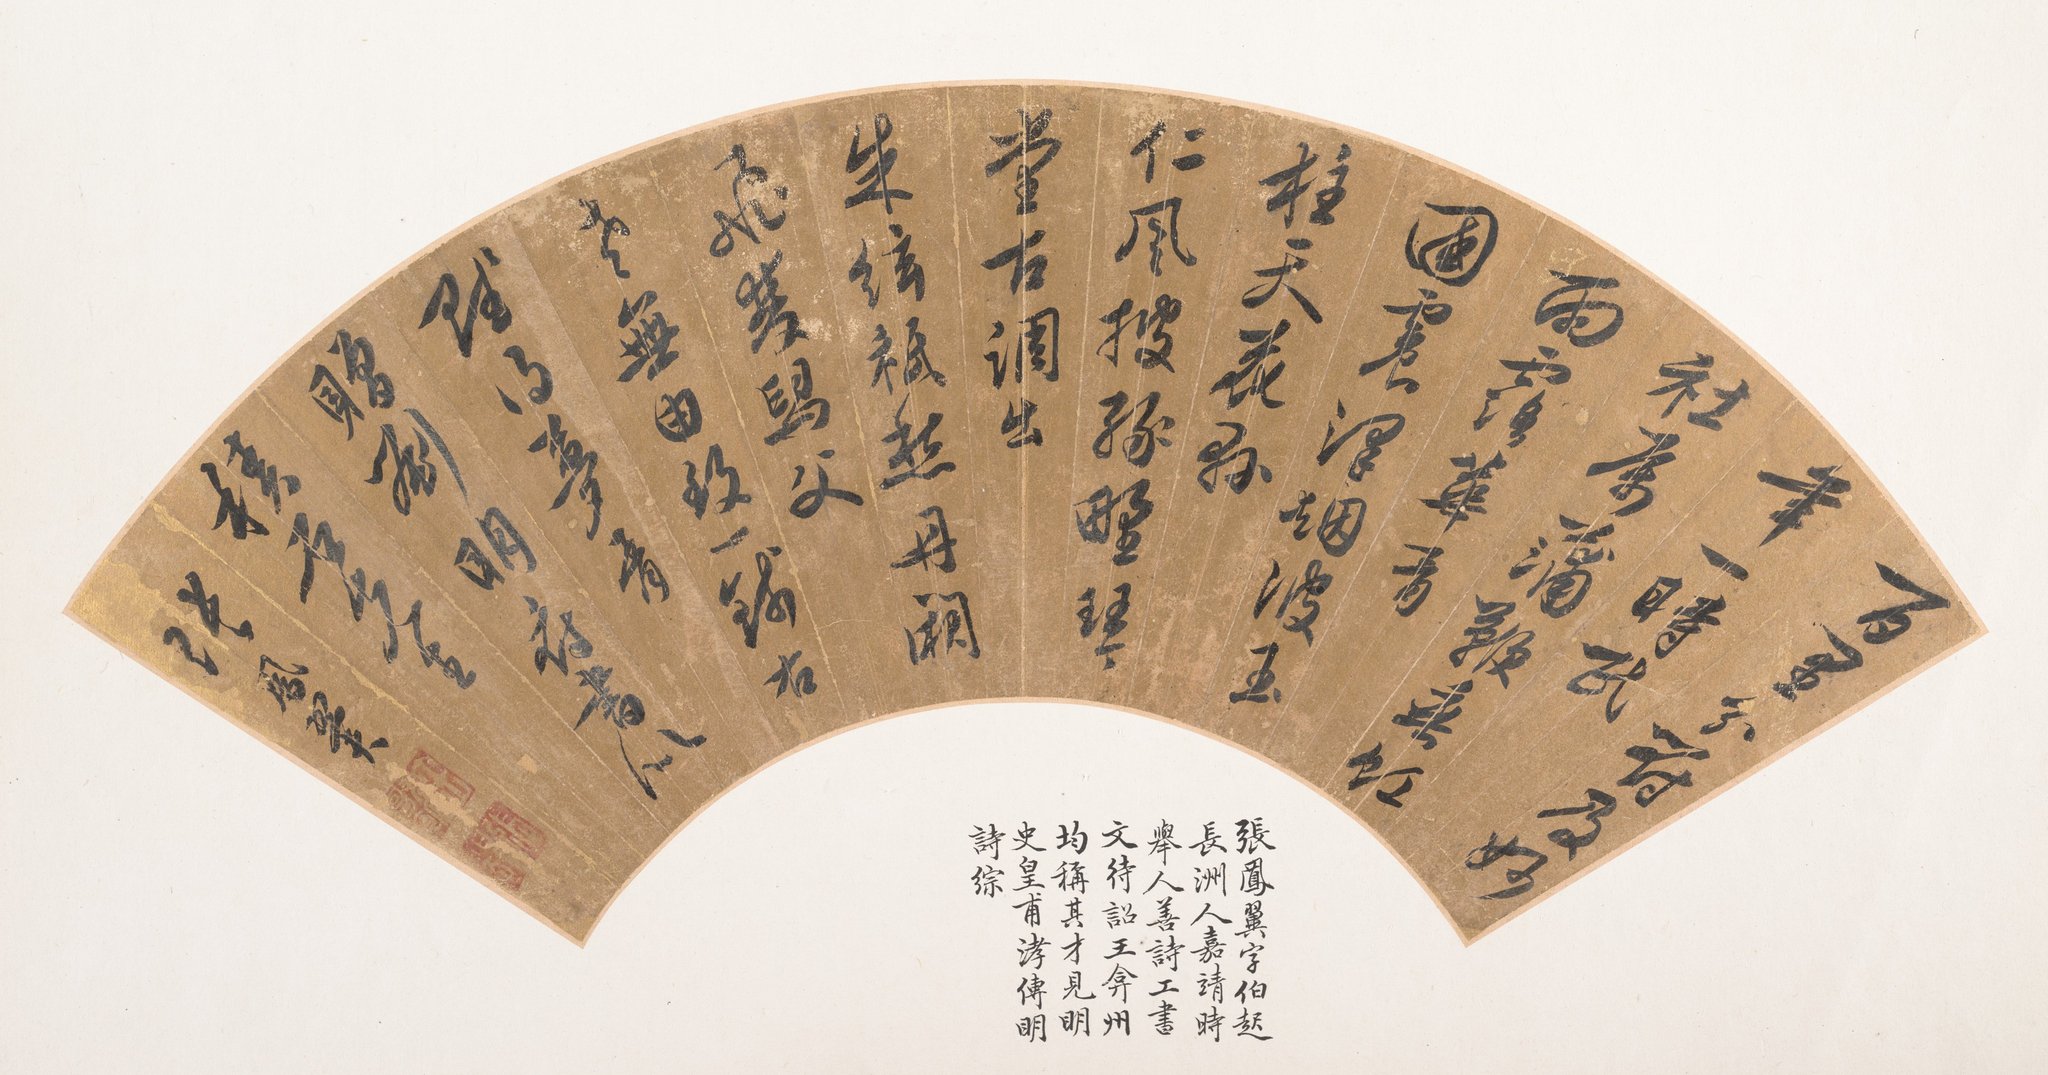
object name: folding fan mounted a an album leaf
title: Poem in Seven-syllable Meter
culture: chinese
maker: zhang fengyi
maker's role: artist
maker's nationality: chinese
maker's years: 1527-1613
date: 1527-1613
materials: gold, ink, paper